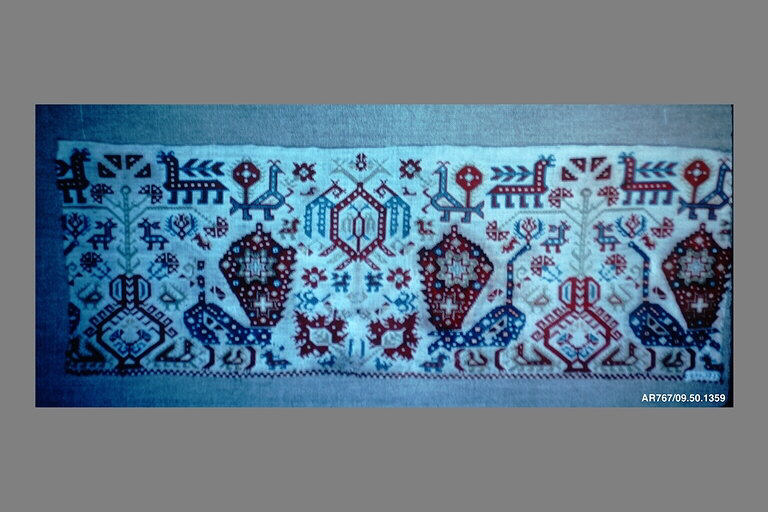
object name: border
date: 1701-1800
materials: linen, silk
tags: birds